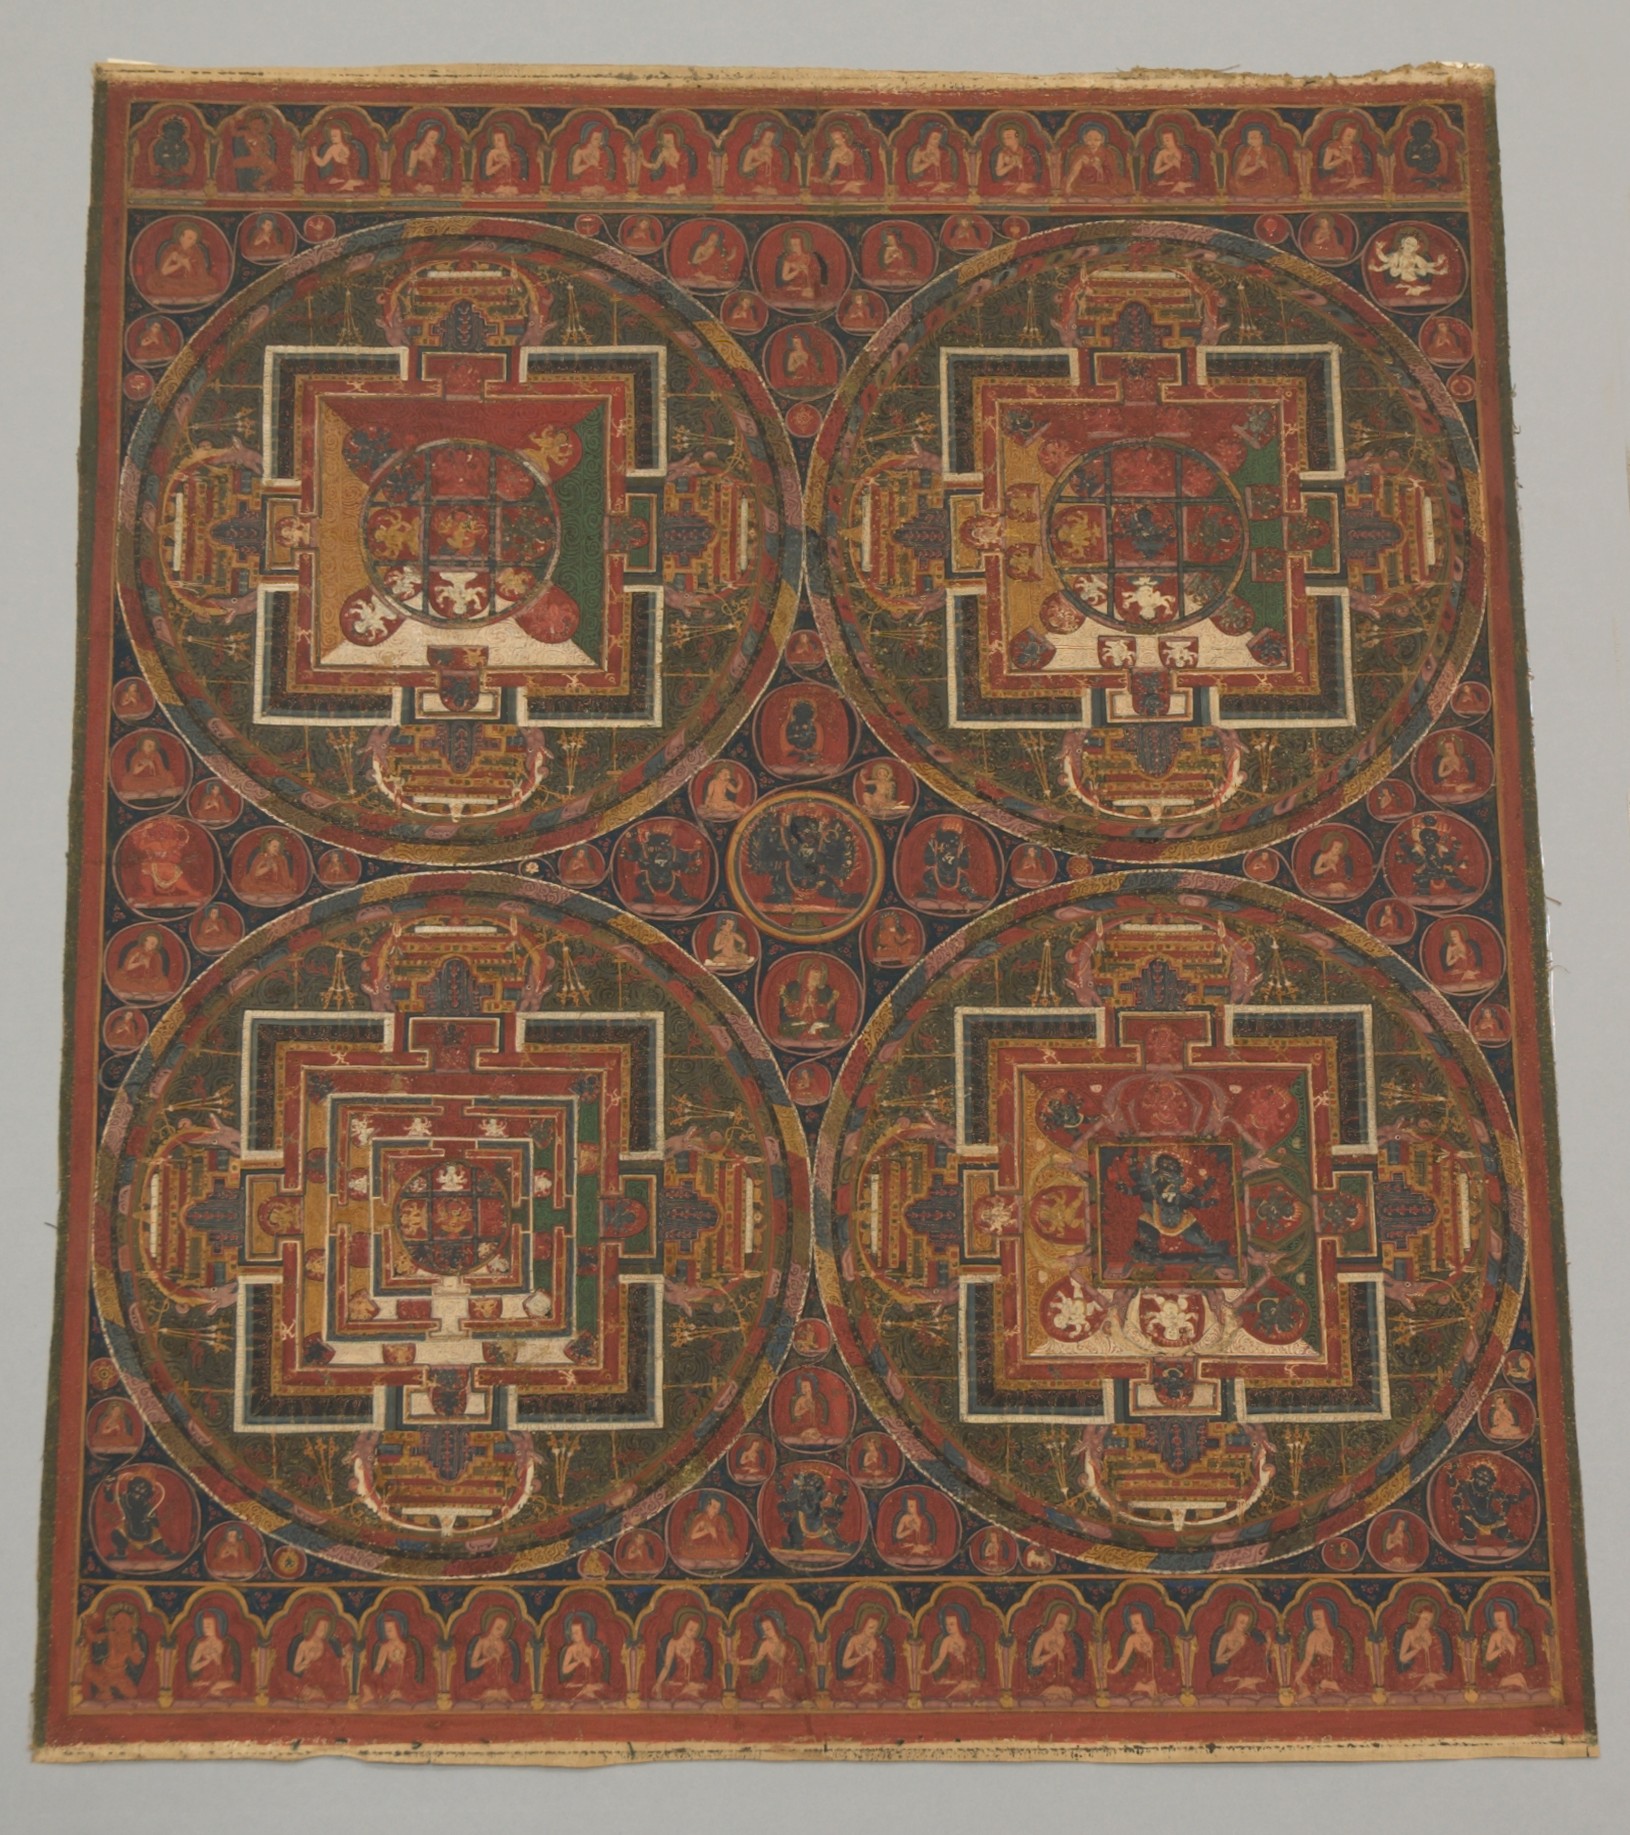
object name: thangka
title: Four Mandalas of the Guhyasamaja Cycle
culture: tibetan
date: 1501-1600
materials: textile, ink